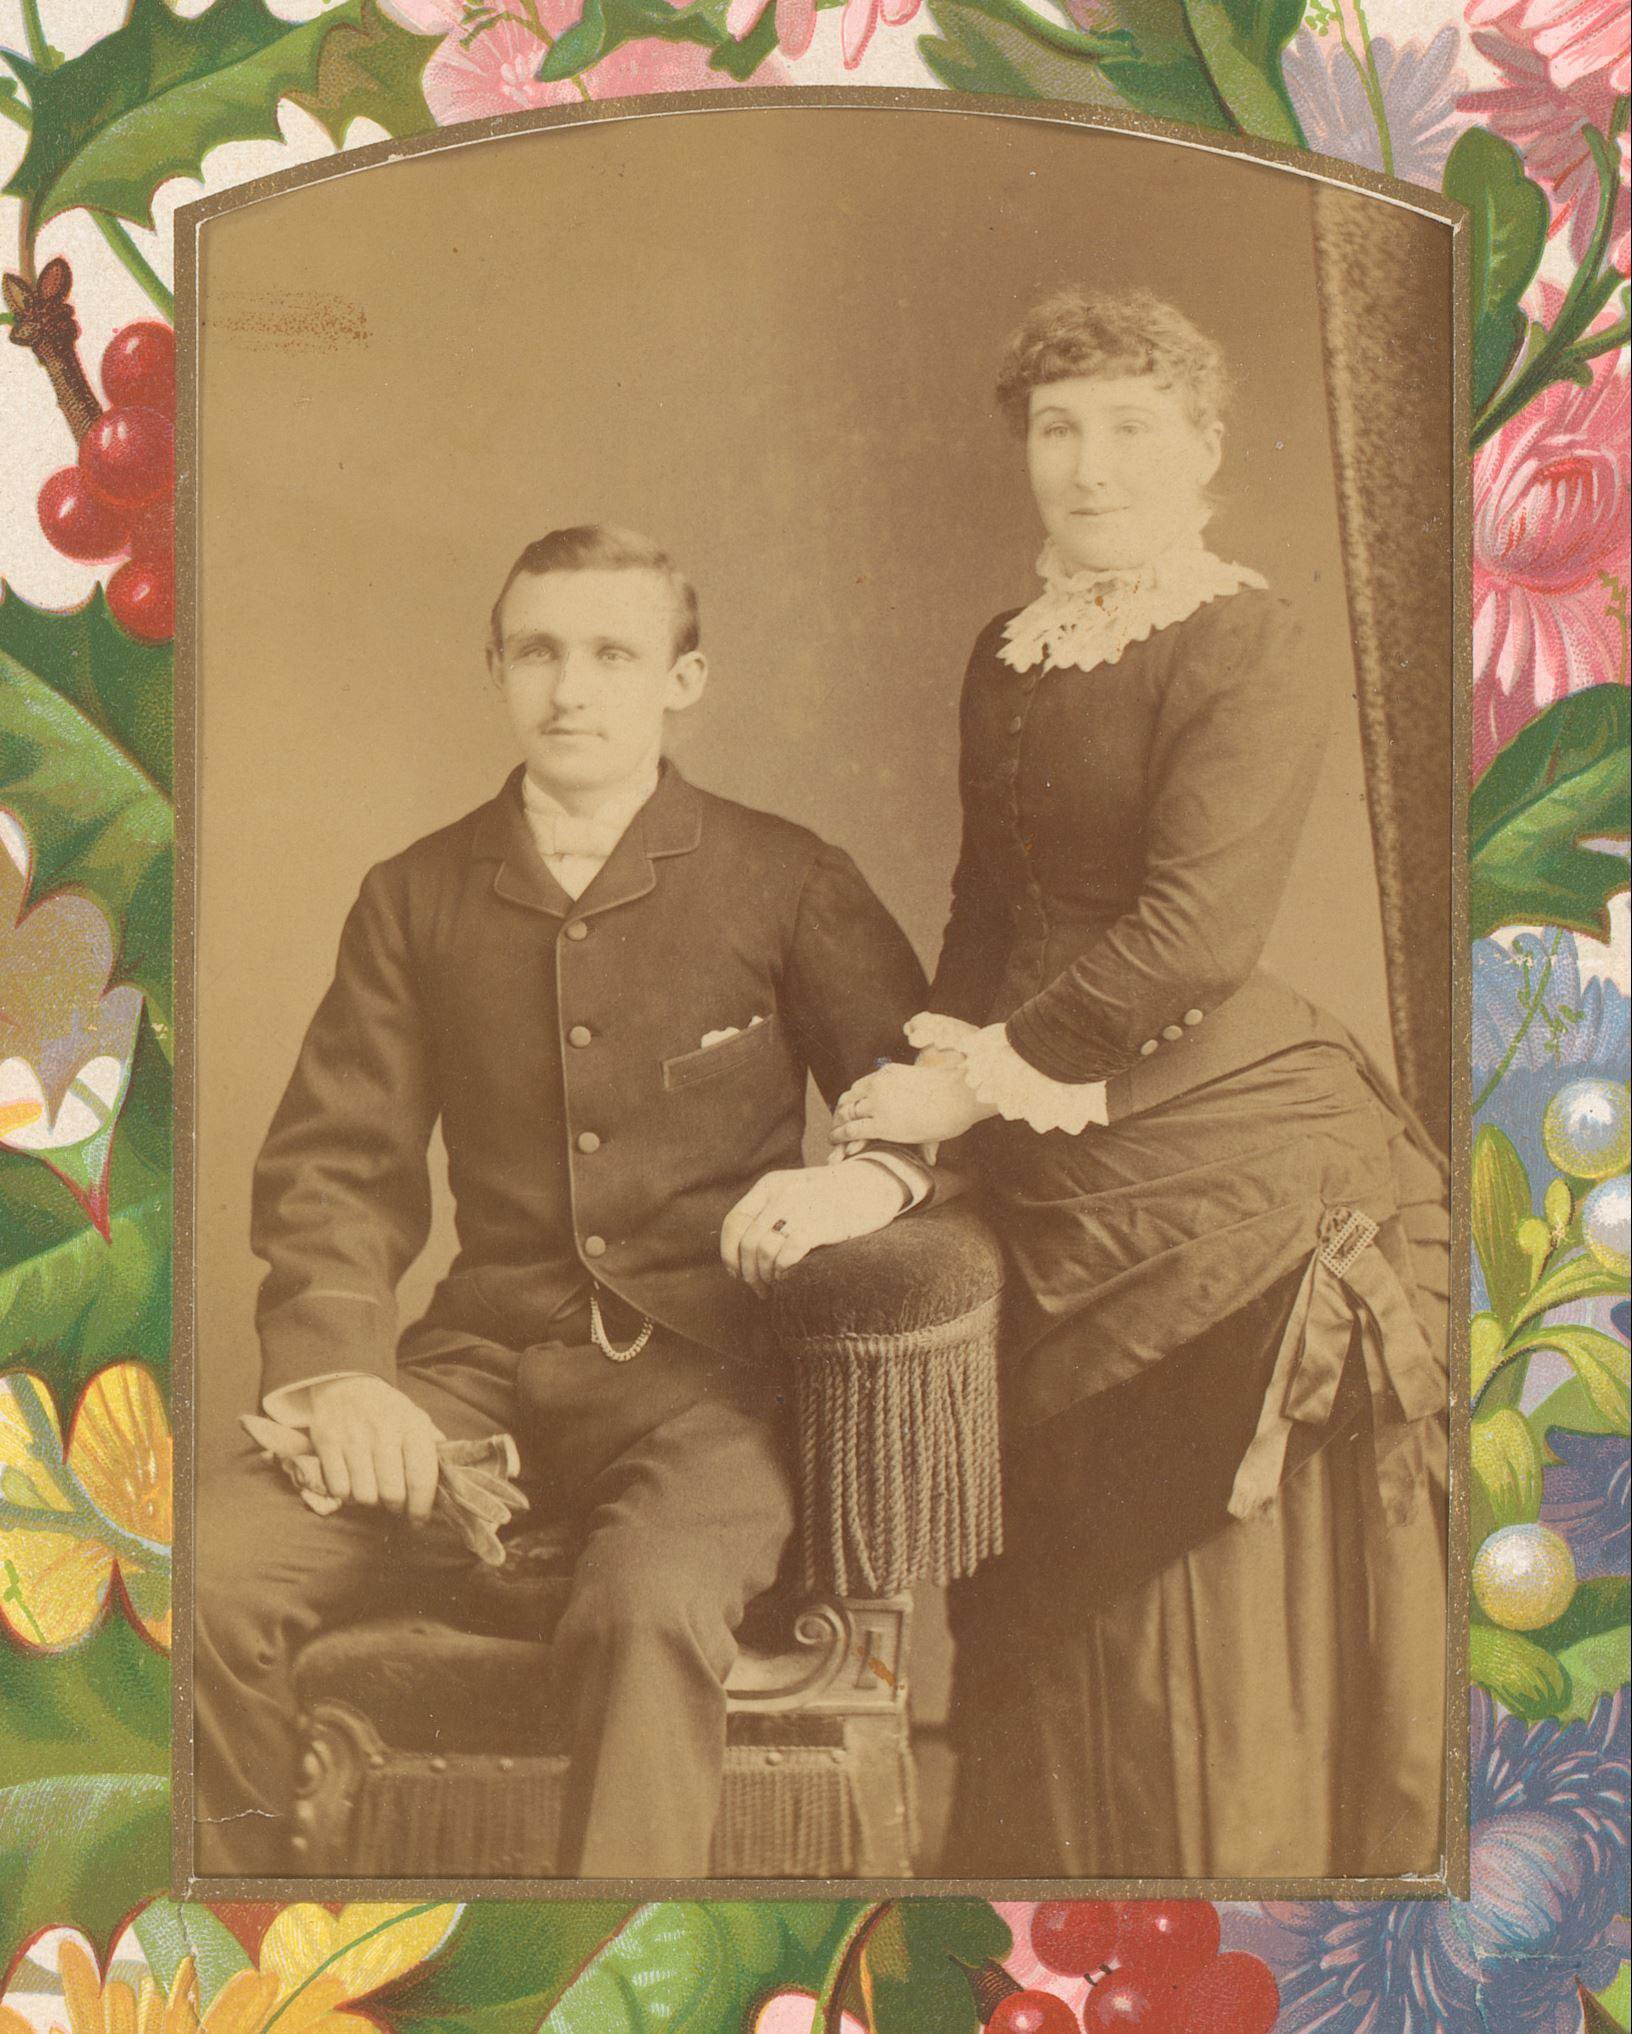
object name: album leaf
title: Portret van een zittende man met handschoenen in zijn hand en een vrouw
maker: b. barry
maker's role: fotograaf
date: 1872-1886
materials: cardboard, paper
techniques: albumen print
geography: london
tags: historical persons - bb - woman, gloves, mittens, etc., adult man, historical persons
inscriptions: address: ‘BARKING ROAD E’, inscription: ‘[...]/ No..../ COPIES OF THIS CAN ALWAYS BE HAD./ A Portrait in any style can be produced/ from this Photograph in Oil, Water Colour/ or Crayon with or without a sitting./ [...]’, number: ‘7106’